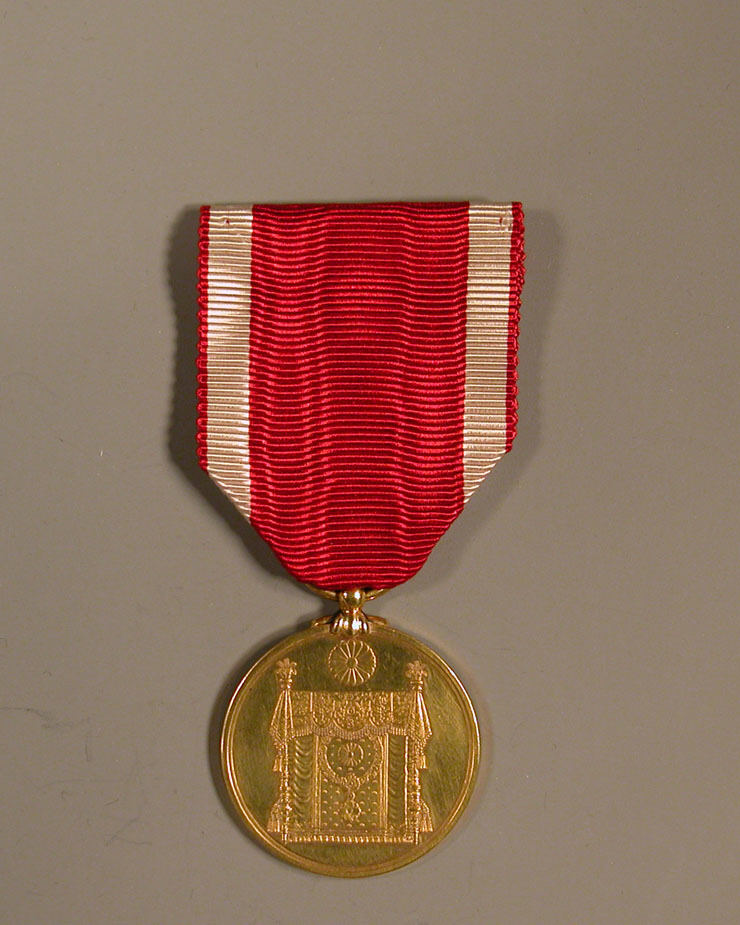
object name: medal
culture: japanese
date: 1867-1900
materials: gold, ribbon